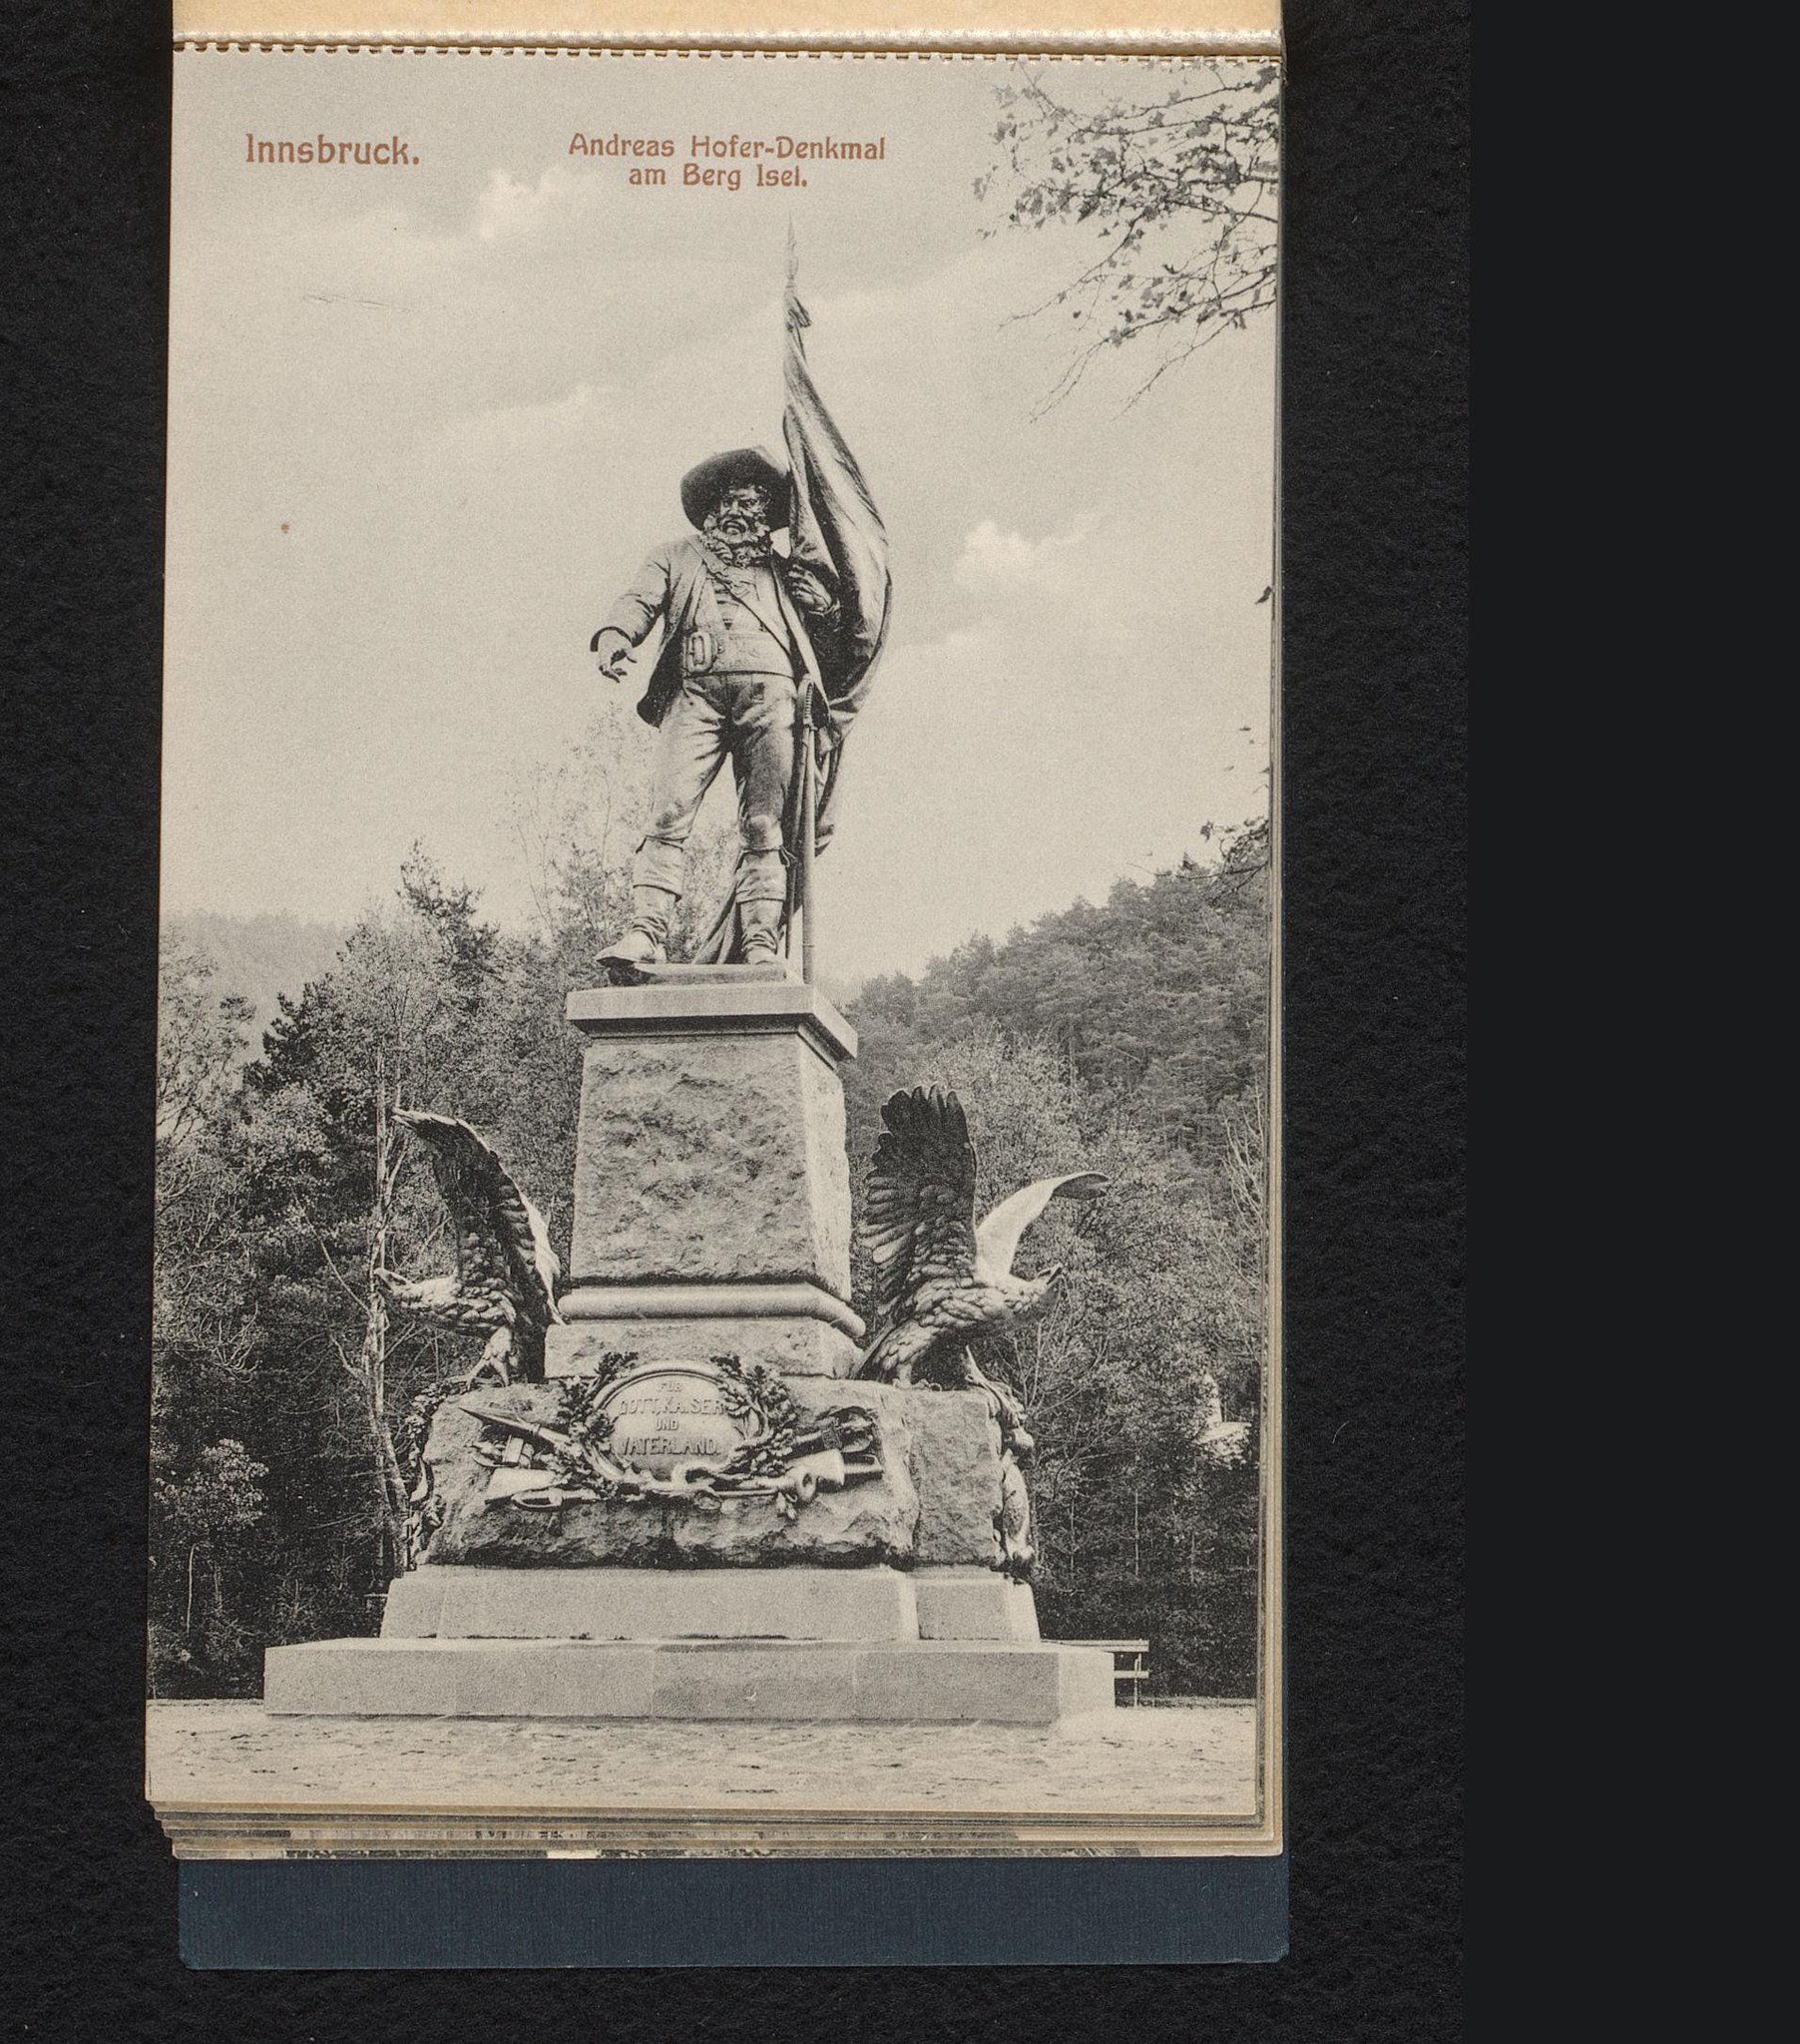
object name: photomechanical print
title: Innsbruck. Andreas Hofer-Denkmal am Berg Isel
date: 1904-1930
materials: cardboard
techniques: photograph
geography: innsbruck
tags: monument, statue